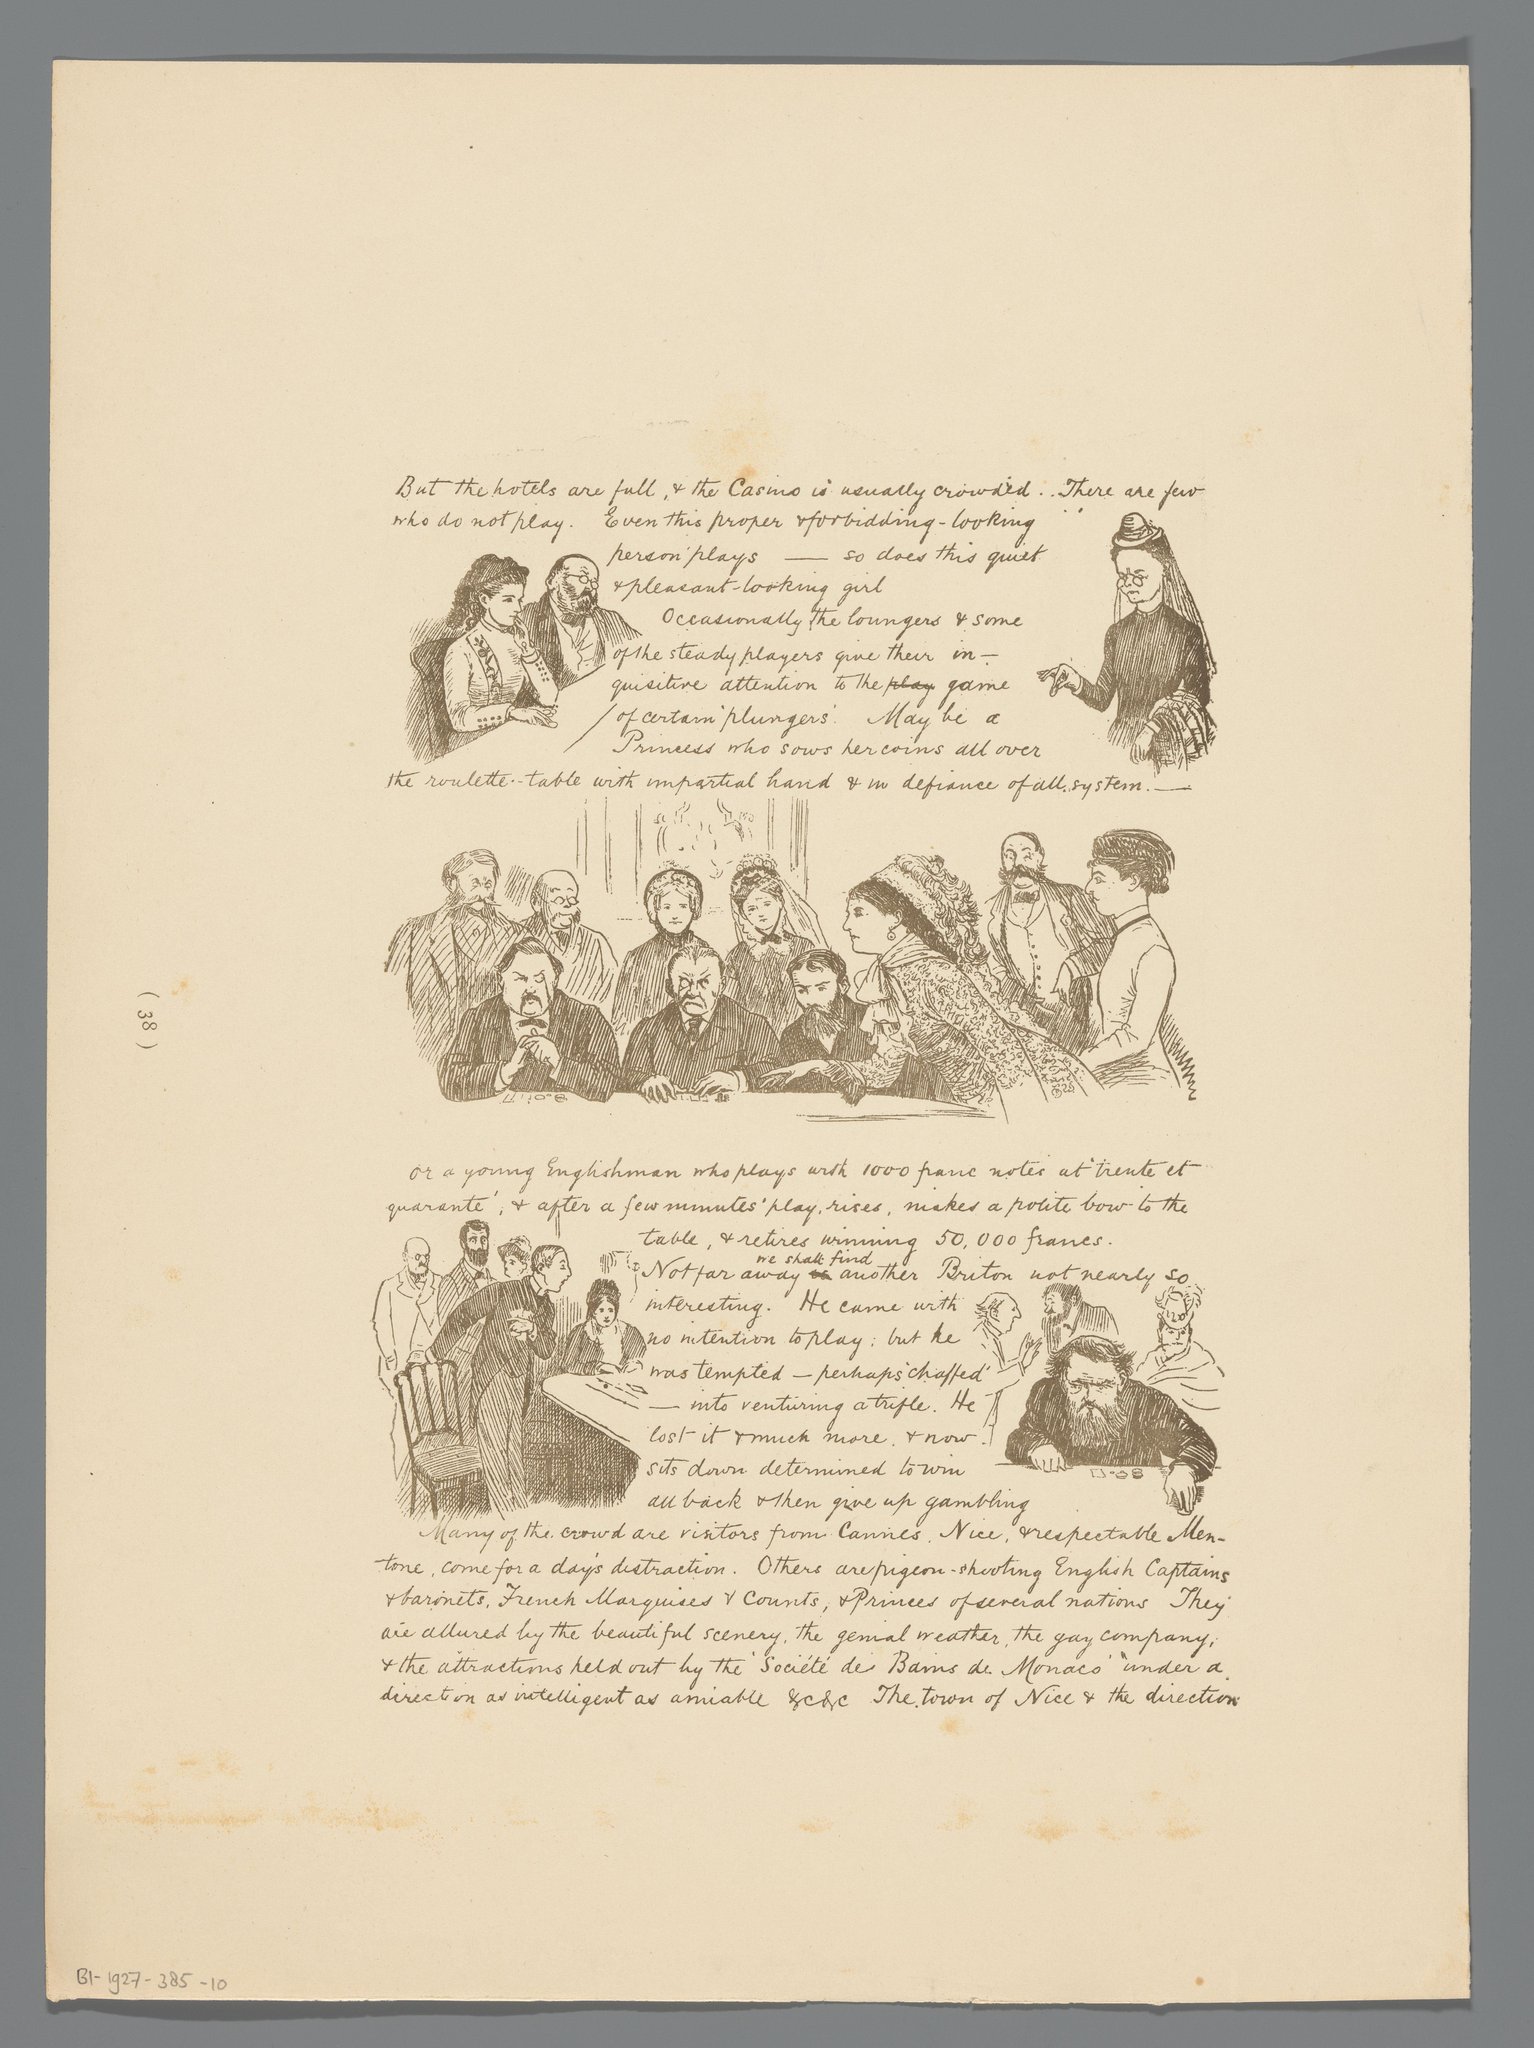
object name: book illustration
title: Voorstellingen van mensen in een casino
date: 1889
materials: paper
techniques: letterpress printing, engraving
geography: london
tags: games of calculation and chance, e.g.: card games, gambling, puzzles, etc., casino, gaming den, gambling den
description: Prent uit: Gleanings from the Graphic. Londen: George Routledge & Sons, 1889. Dit werk is een bundel van diverse illustraties die eerder verschenen in verschillende jaargangen van het Engelse weekblad 'The Graphic'. De bundel is na het overlijden van Randolph Caldecott uitgegeven.